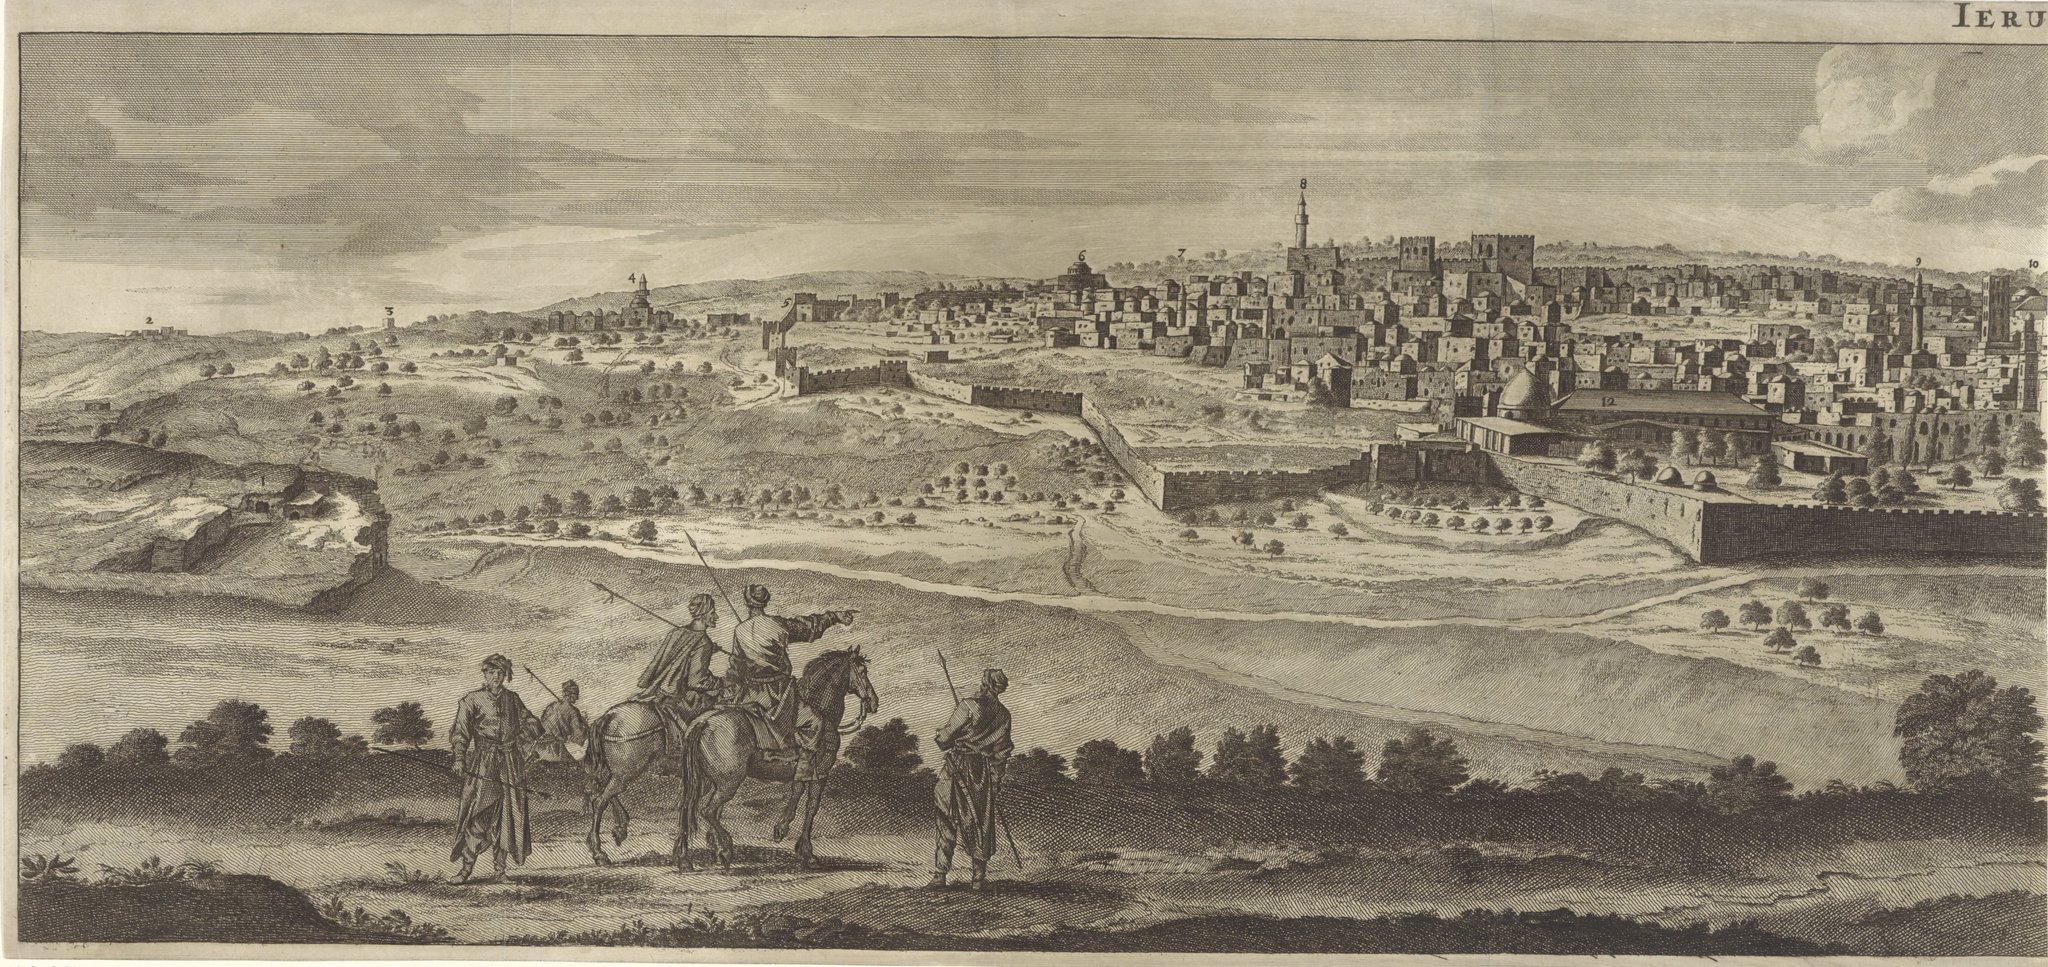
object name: print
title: Gezicht op Jeruzalem (linker plaat)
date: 1698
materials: paper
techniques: engraving, etching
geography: delft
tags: city-view in general; 'veduta'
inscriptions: collector's mark: Lugt 2228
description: Illustratie voor: Bruyn, Cornelis de. Reizen van Cornelis de Bruyn, door de vermaardste deelen van Klein Asia. Delft: Hendrik van Kroonevelt, 1698, p. 280.